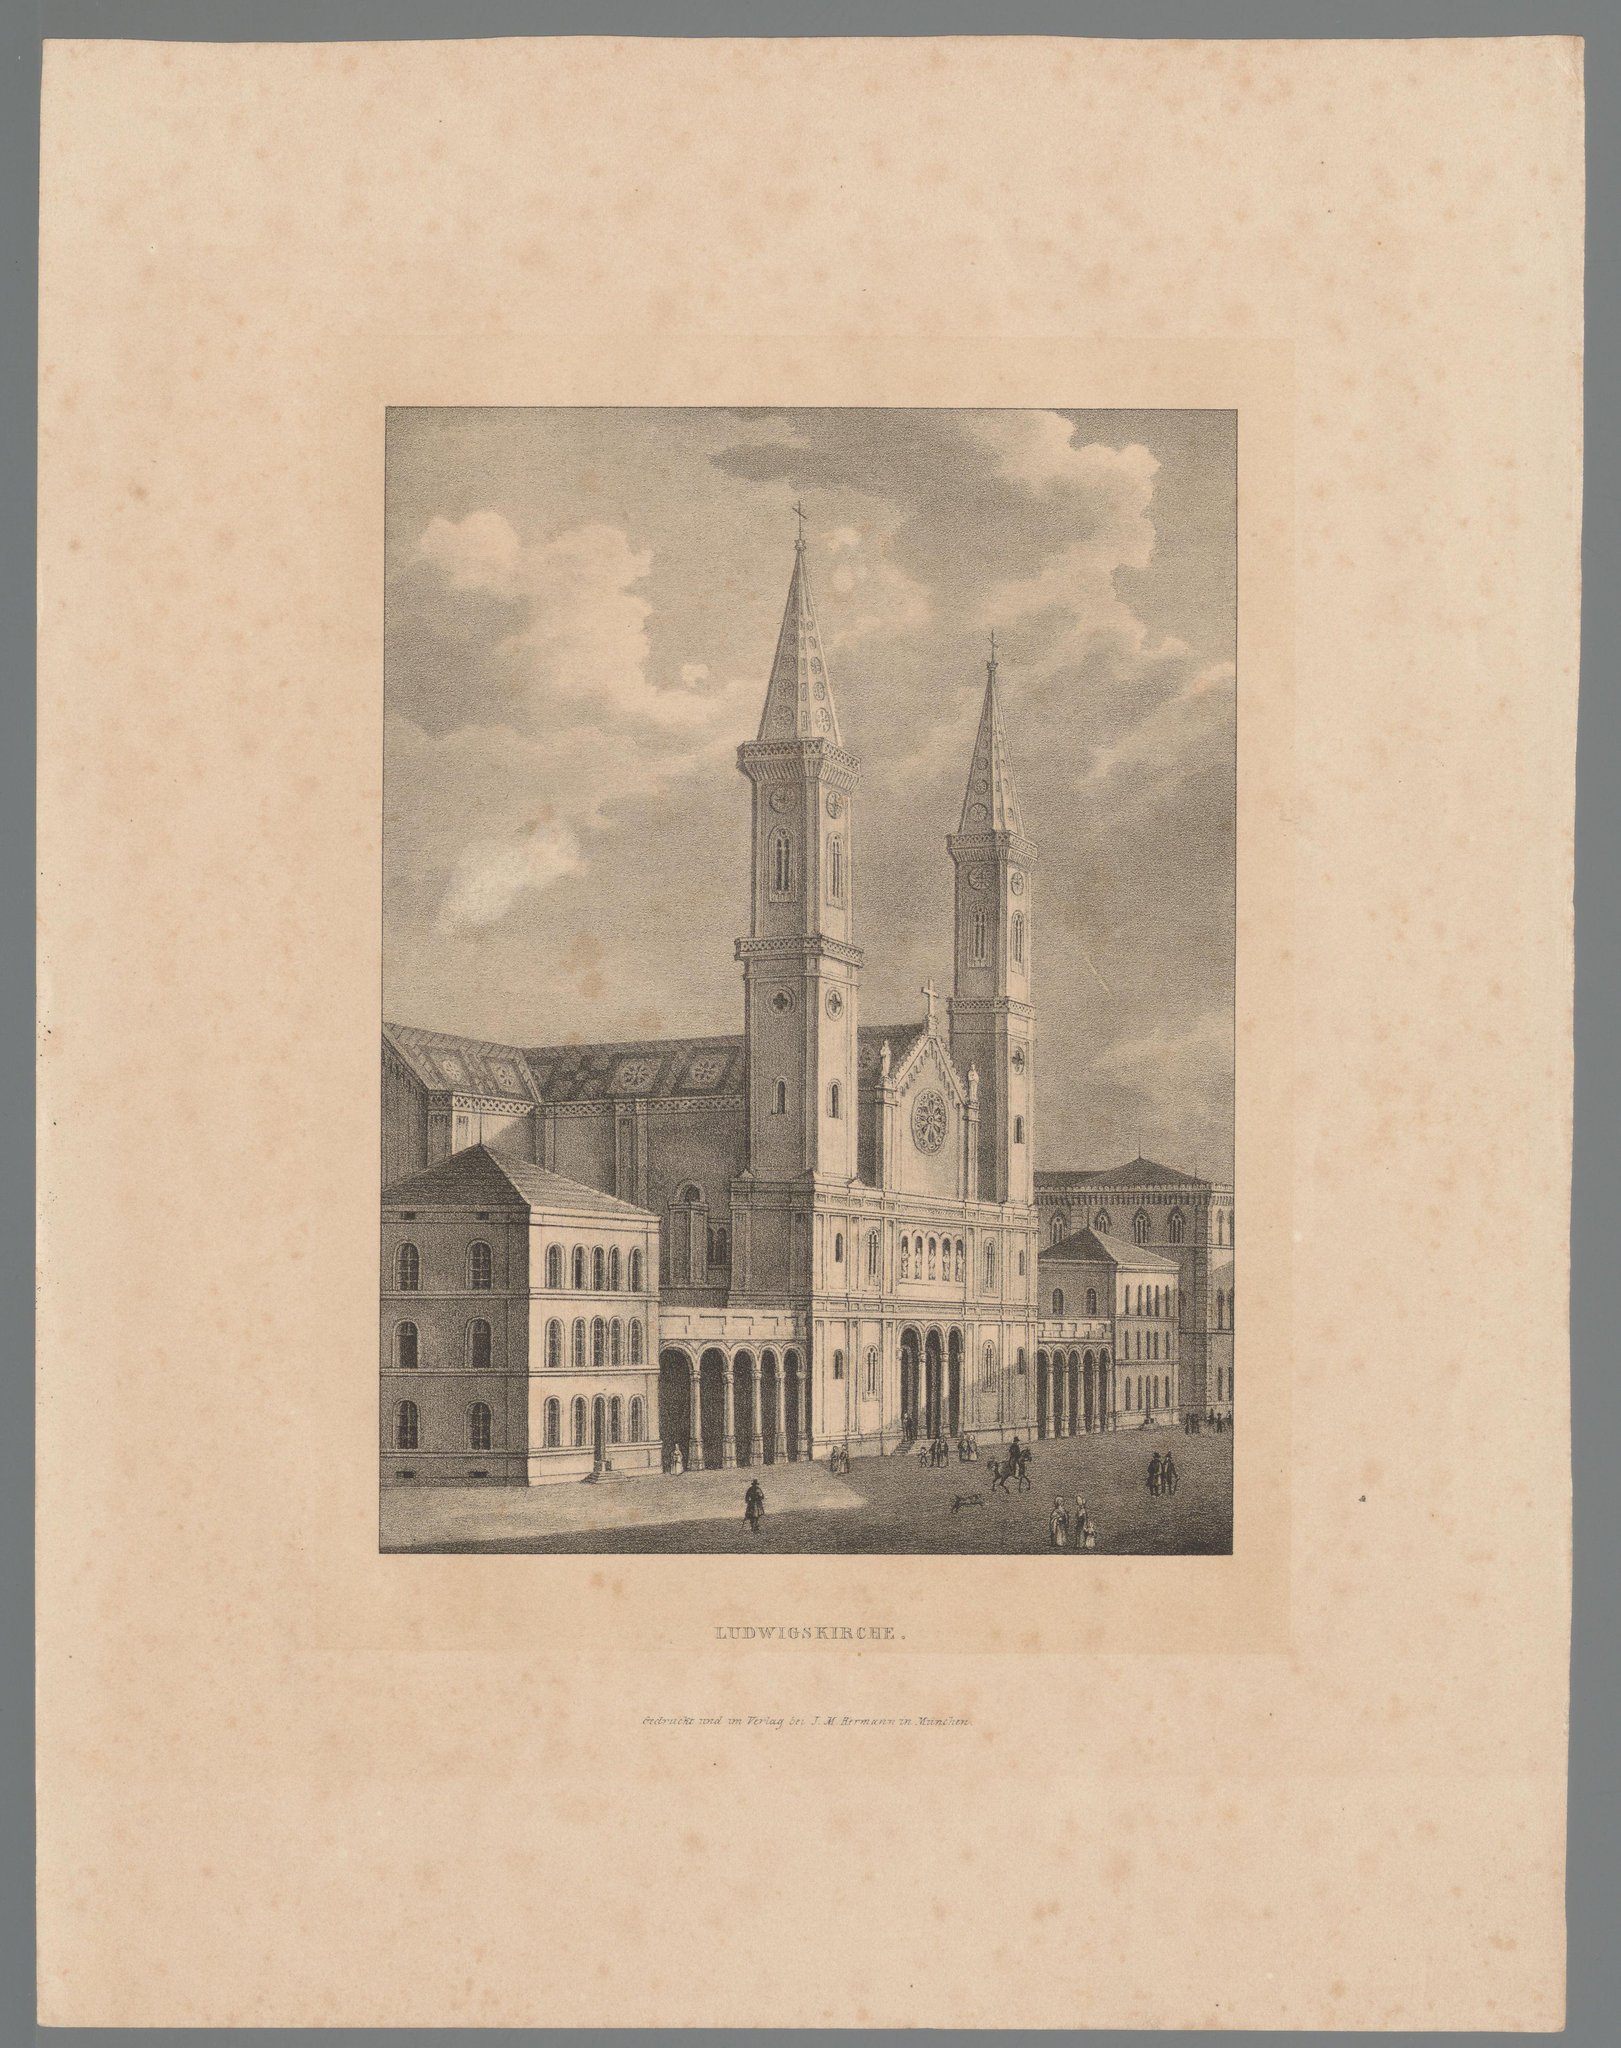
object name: print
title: Ludwigskirche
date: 1797-1862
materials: paper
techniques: lithograph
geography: munich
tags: city-view in general; 'veduta', church (exterior)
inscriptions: collector's mark: Lugt 2228